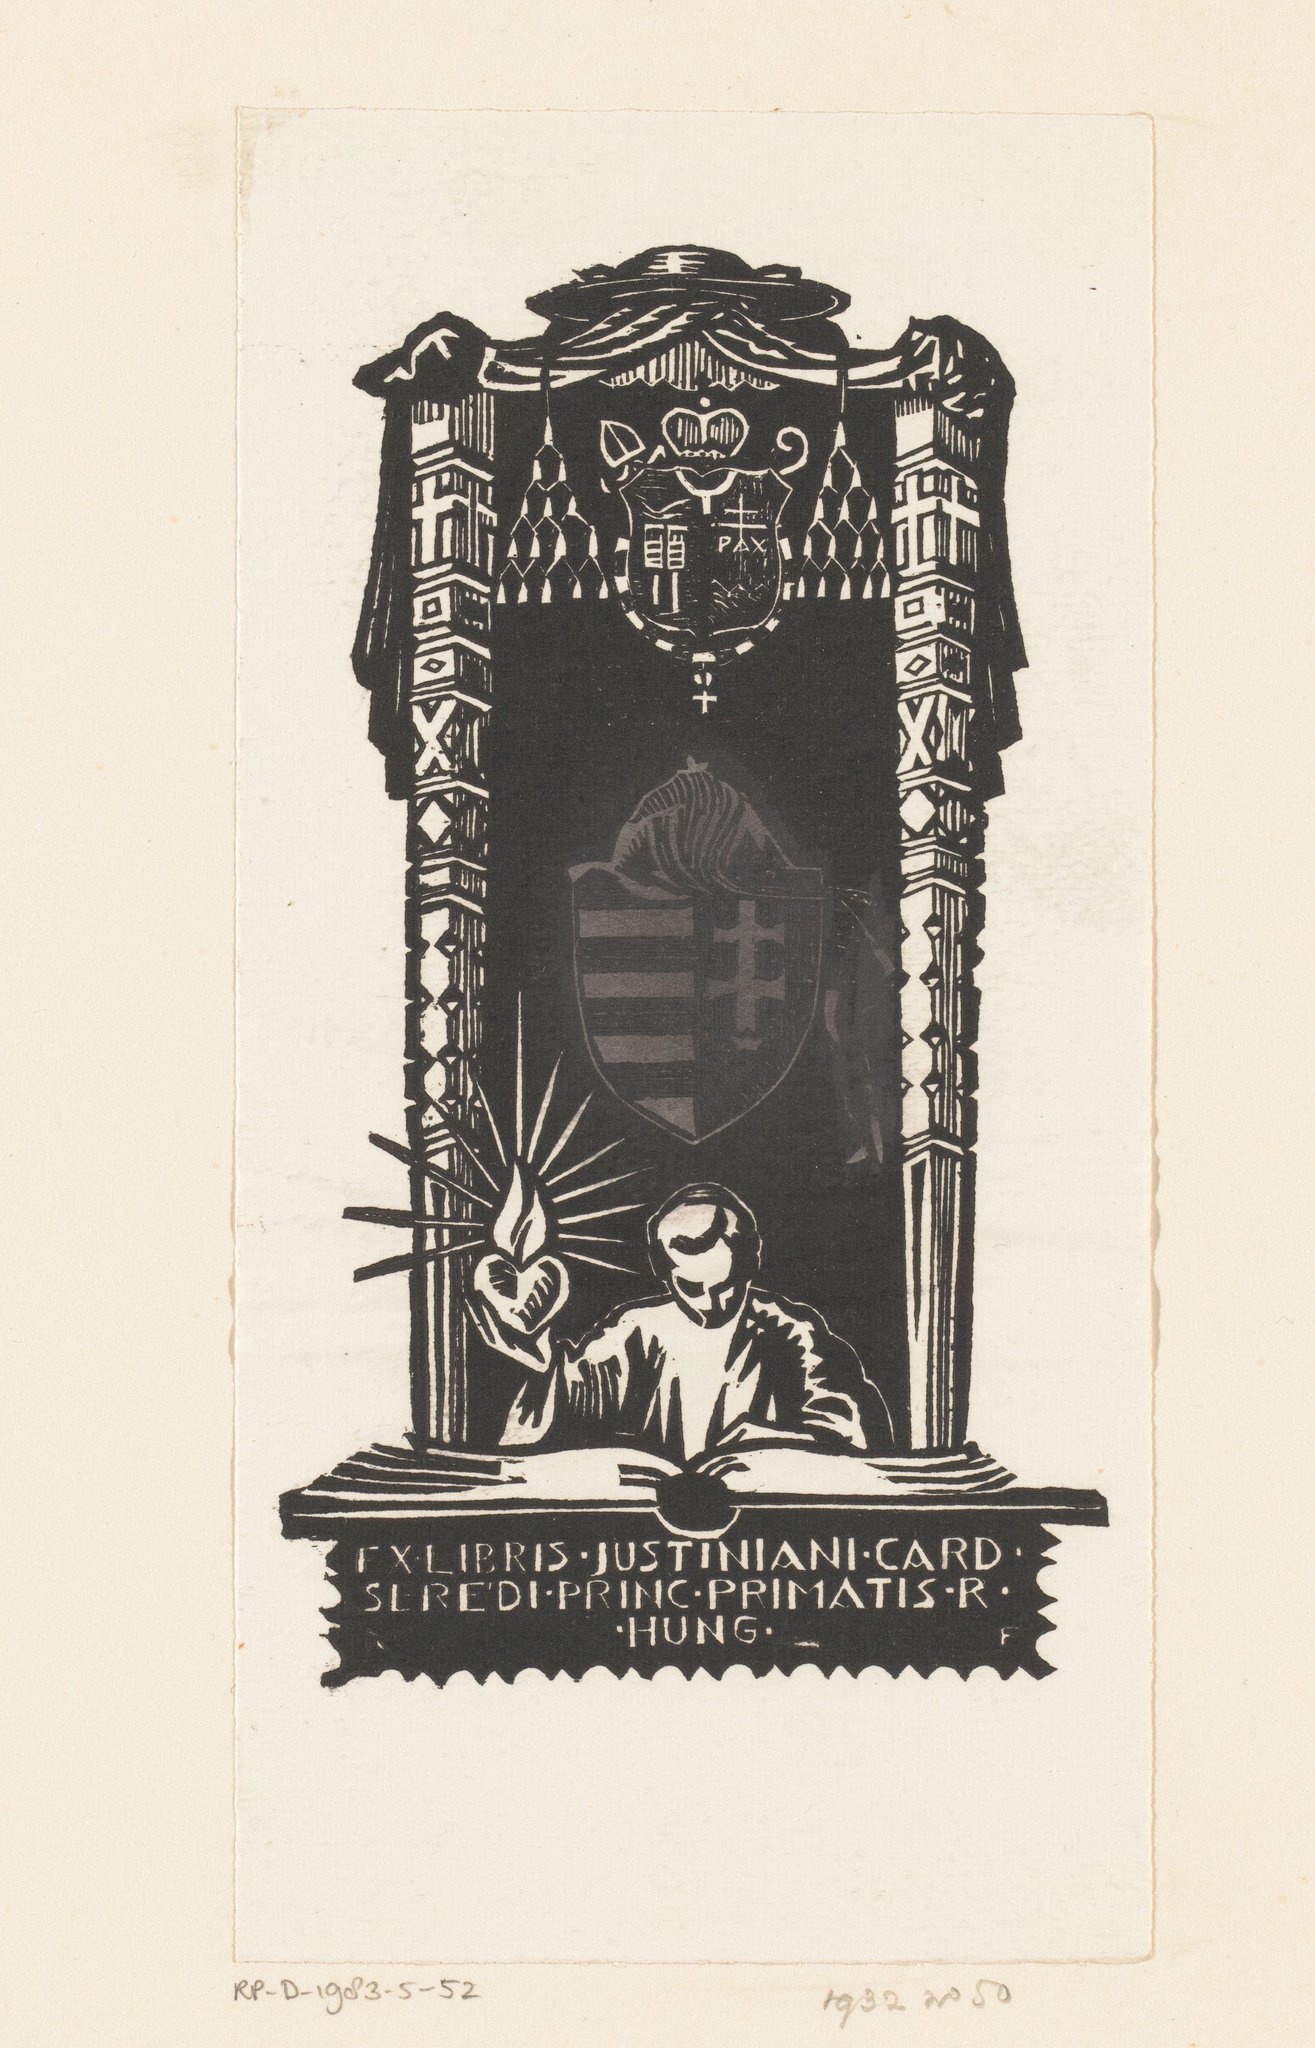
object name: bookplate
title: Ex libris Justiniani card. Serédi princ/ primatis r. Hung.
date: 1932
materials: paper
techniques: woodcut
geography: budapest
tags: heart symbolism, cardinal, book, armorial bearing, heraldry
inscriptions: inscription: ‘1931/ No 50’, workshop stamp: ‘Fecit/ Révész Kornél/ Budapest’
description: Ex libris maakt deel uit van omslag met 64 ex libris op 34 losse opzetvellen, een catalogus en een tekstblad.